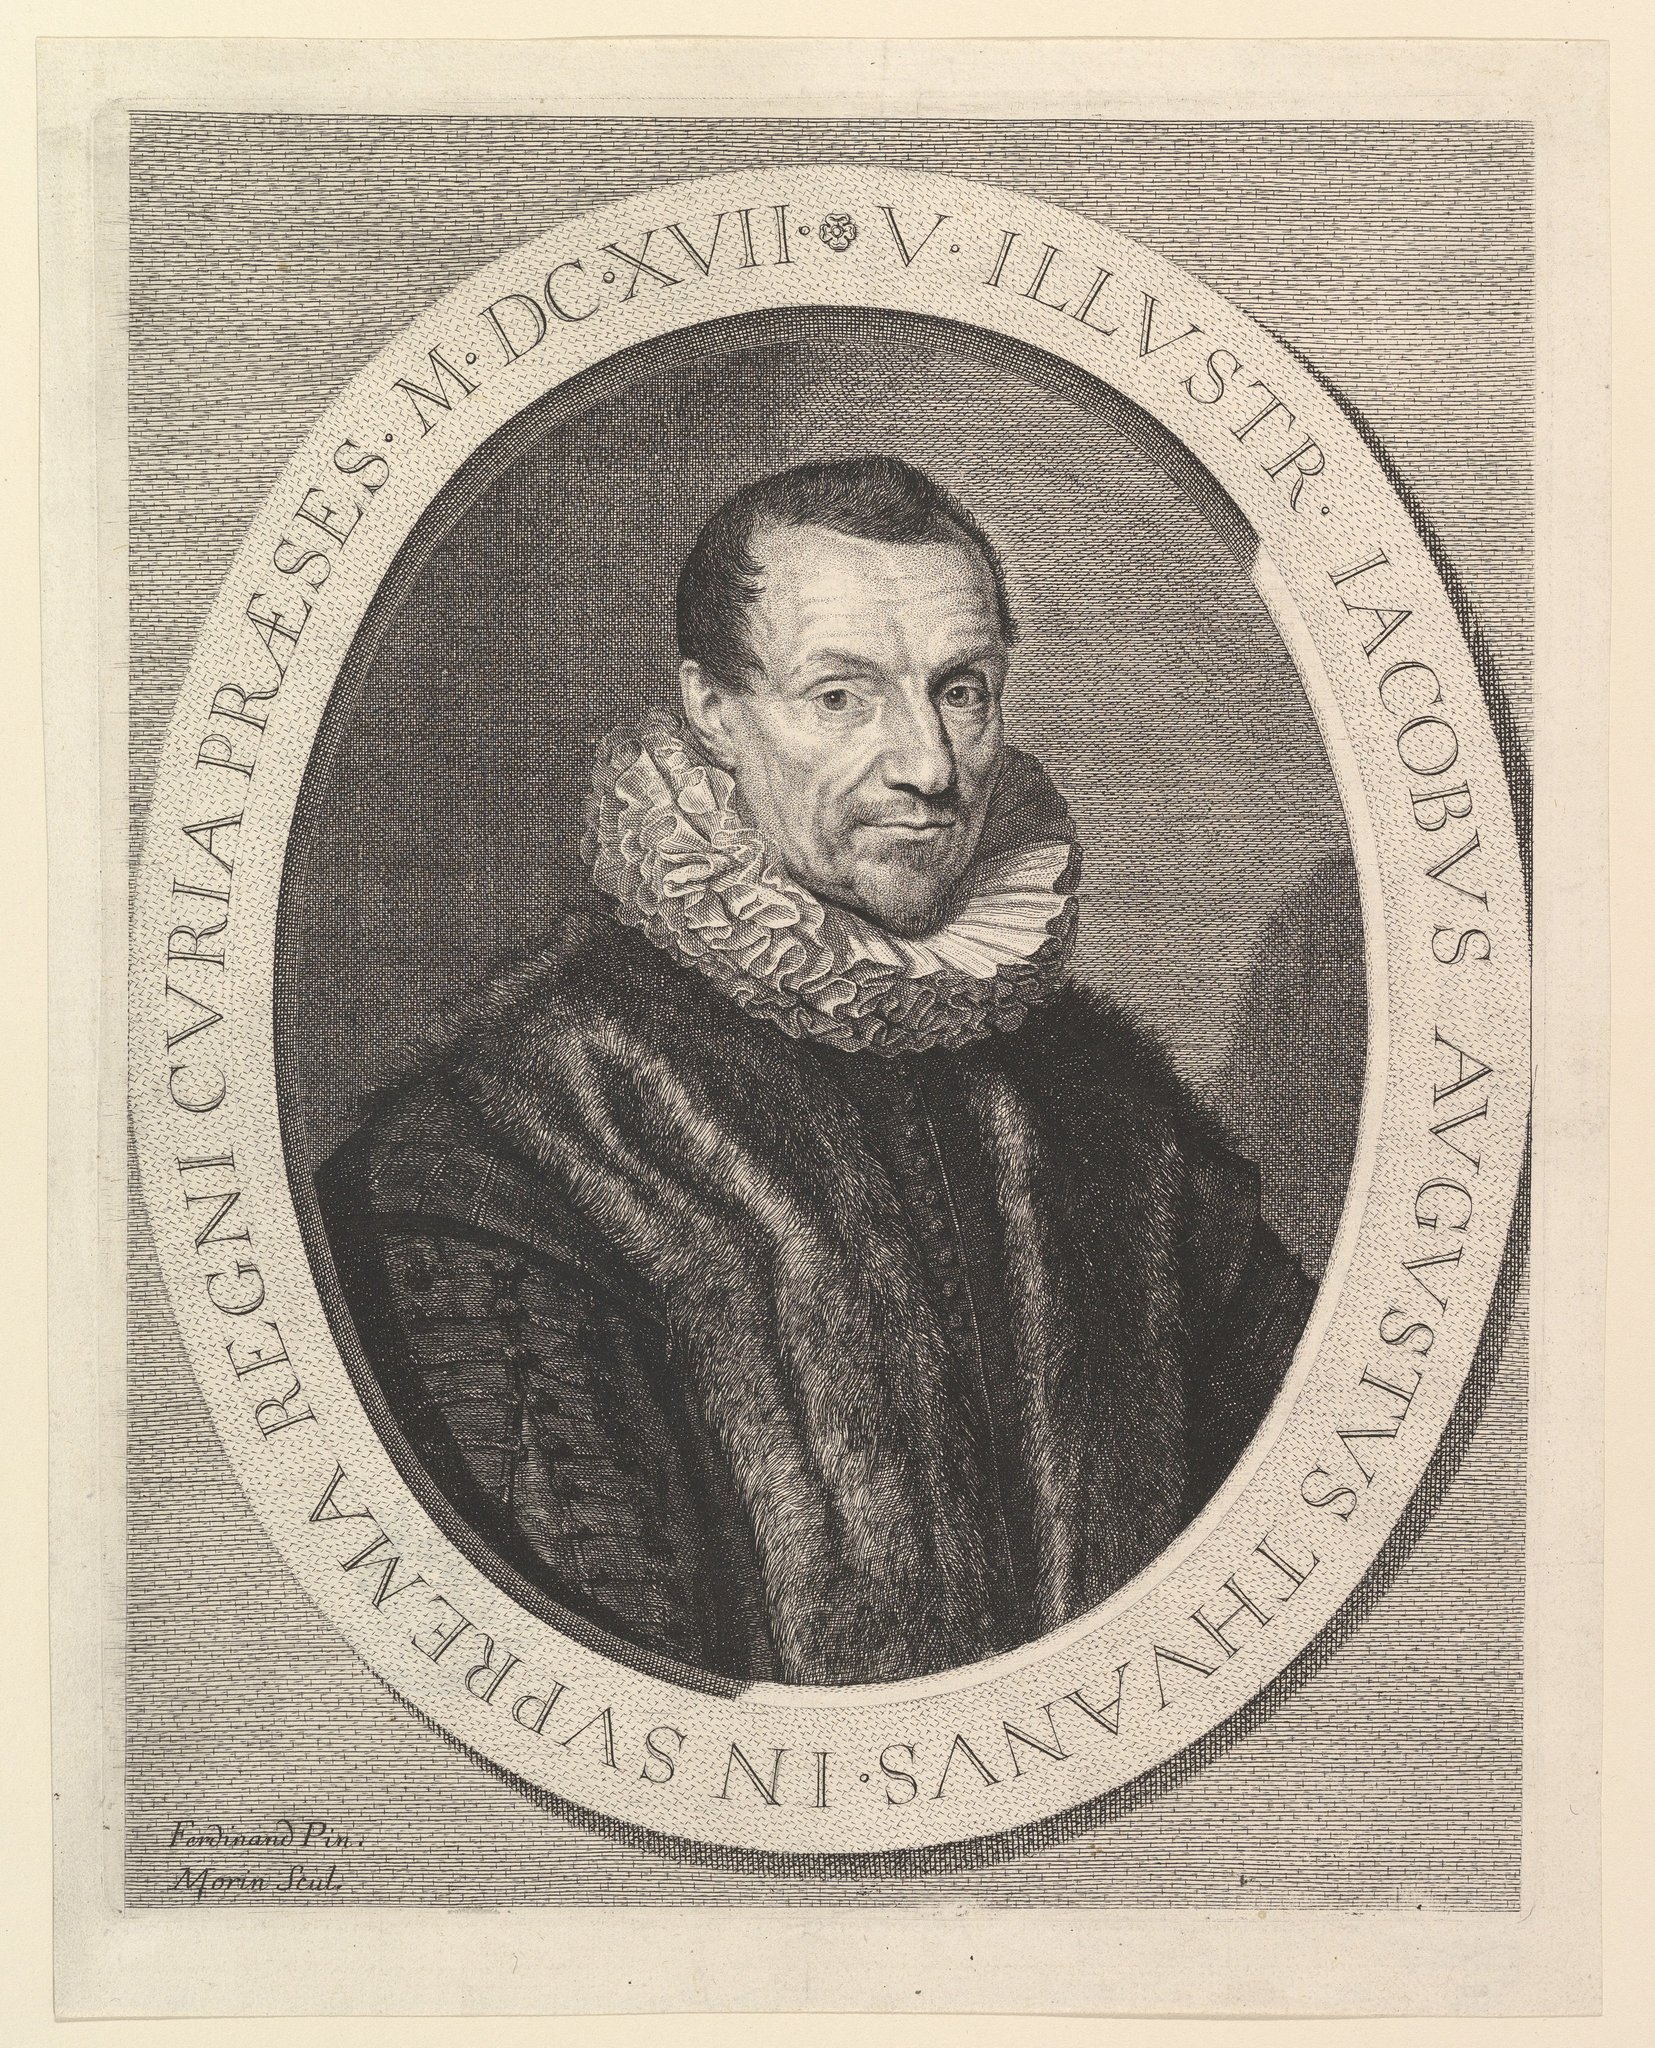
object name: print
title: Jacques-Auguste de Thou, premier president au Parlement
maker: jean morin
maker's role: artist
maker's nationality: french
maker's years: 1605-1650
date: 1605-1650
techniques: etching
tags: men,portraits